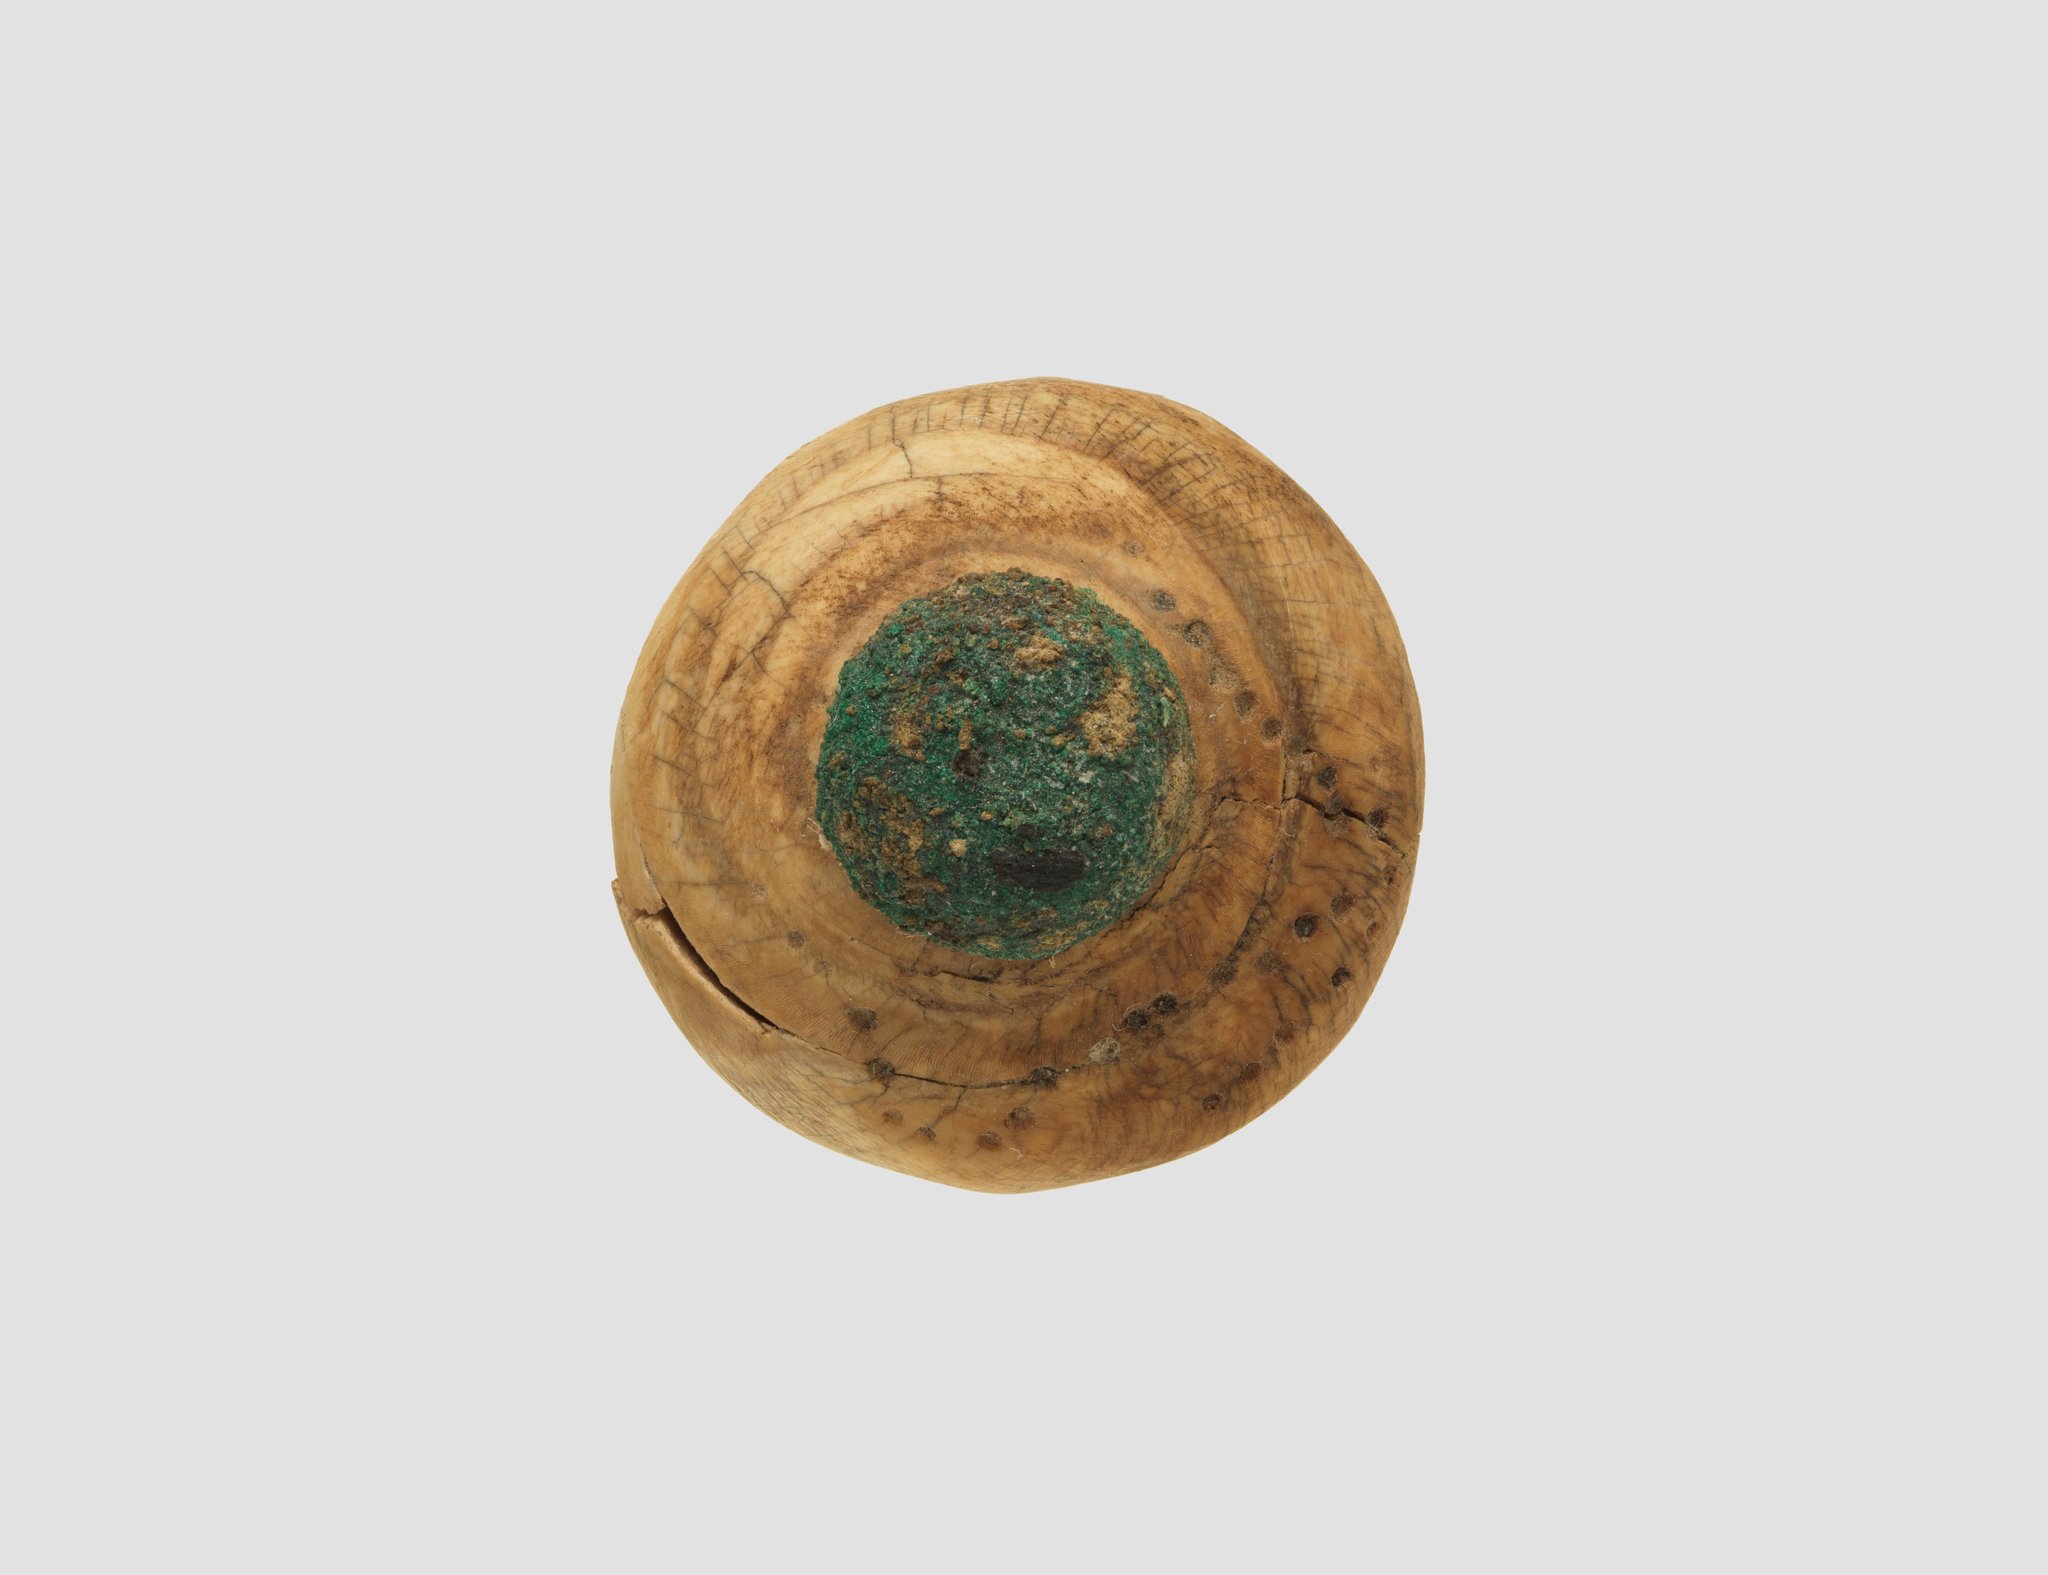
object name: stud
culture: iranian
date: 900-801 BCE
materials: bone, copper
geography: iran